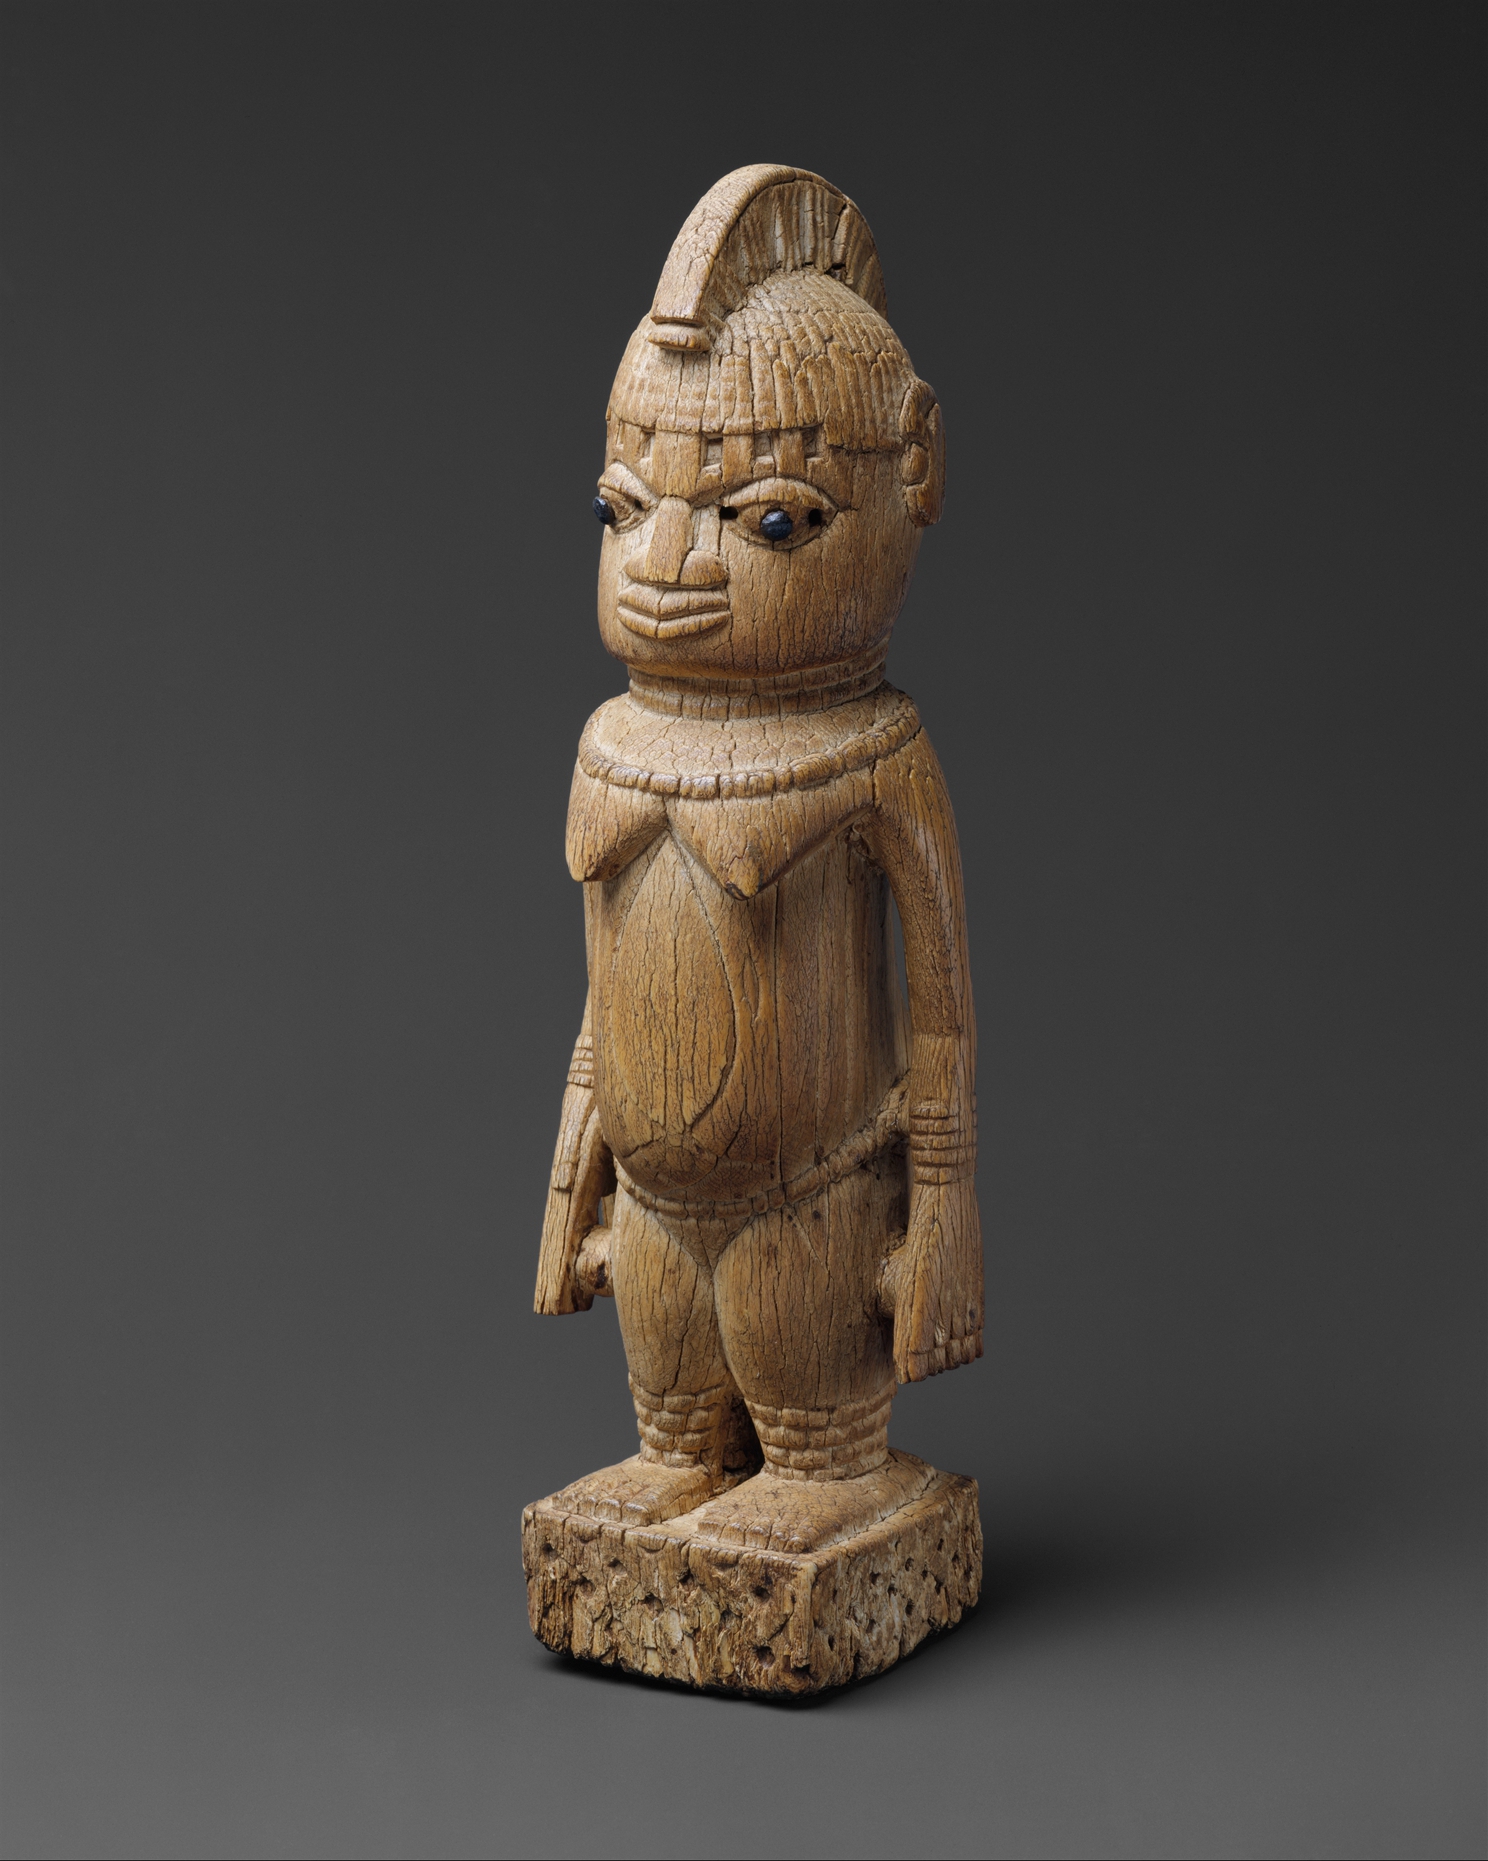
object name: female figure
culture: edo period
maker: ìgbèsànmwà (ivory- and wood- carving guild) artists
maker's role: artist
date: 1701-1800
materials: ivory, metal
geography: nigeria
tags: female nudes